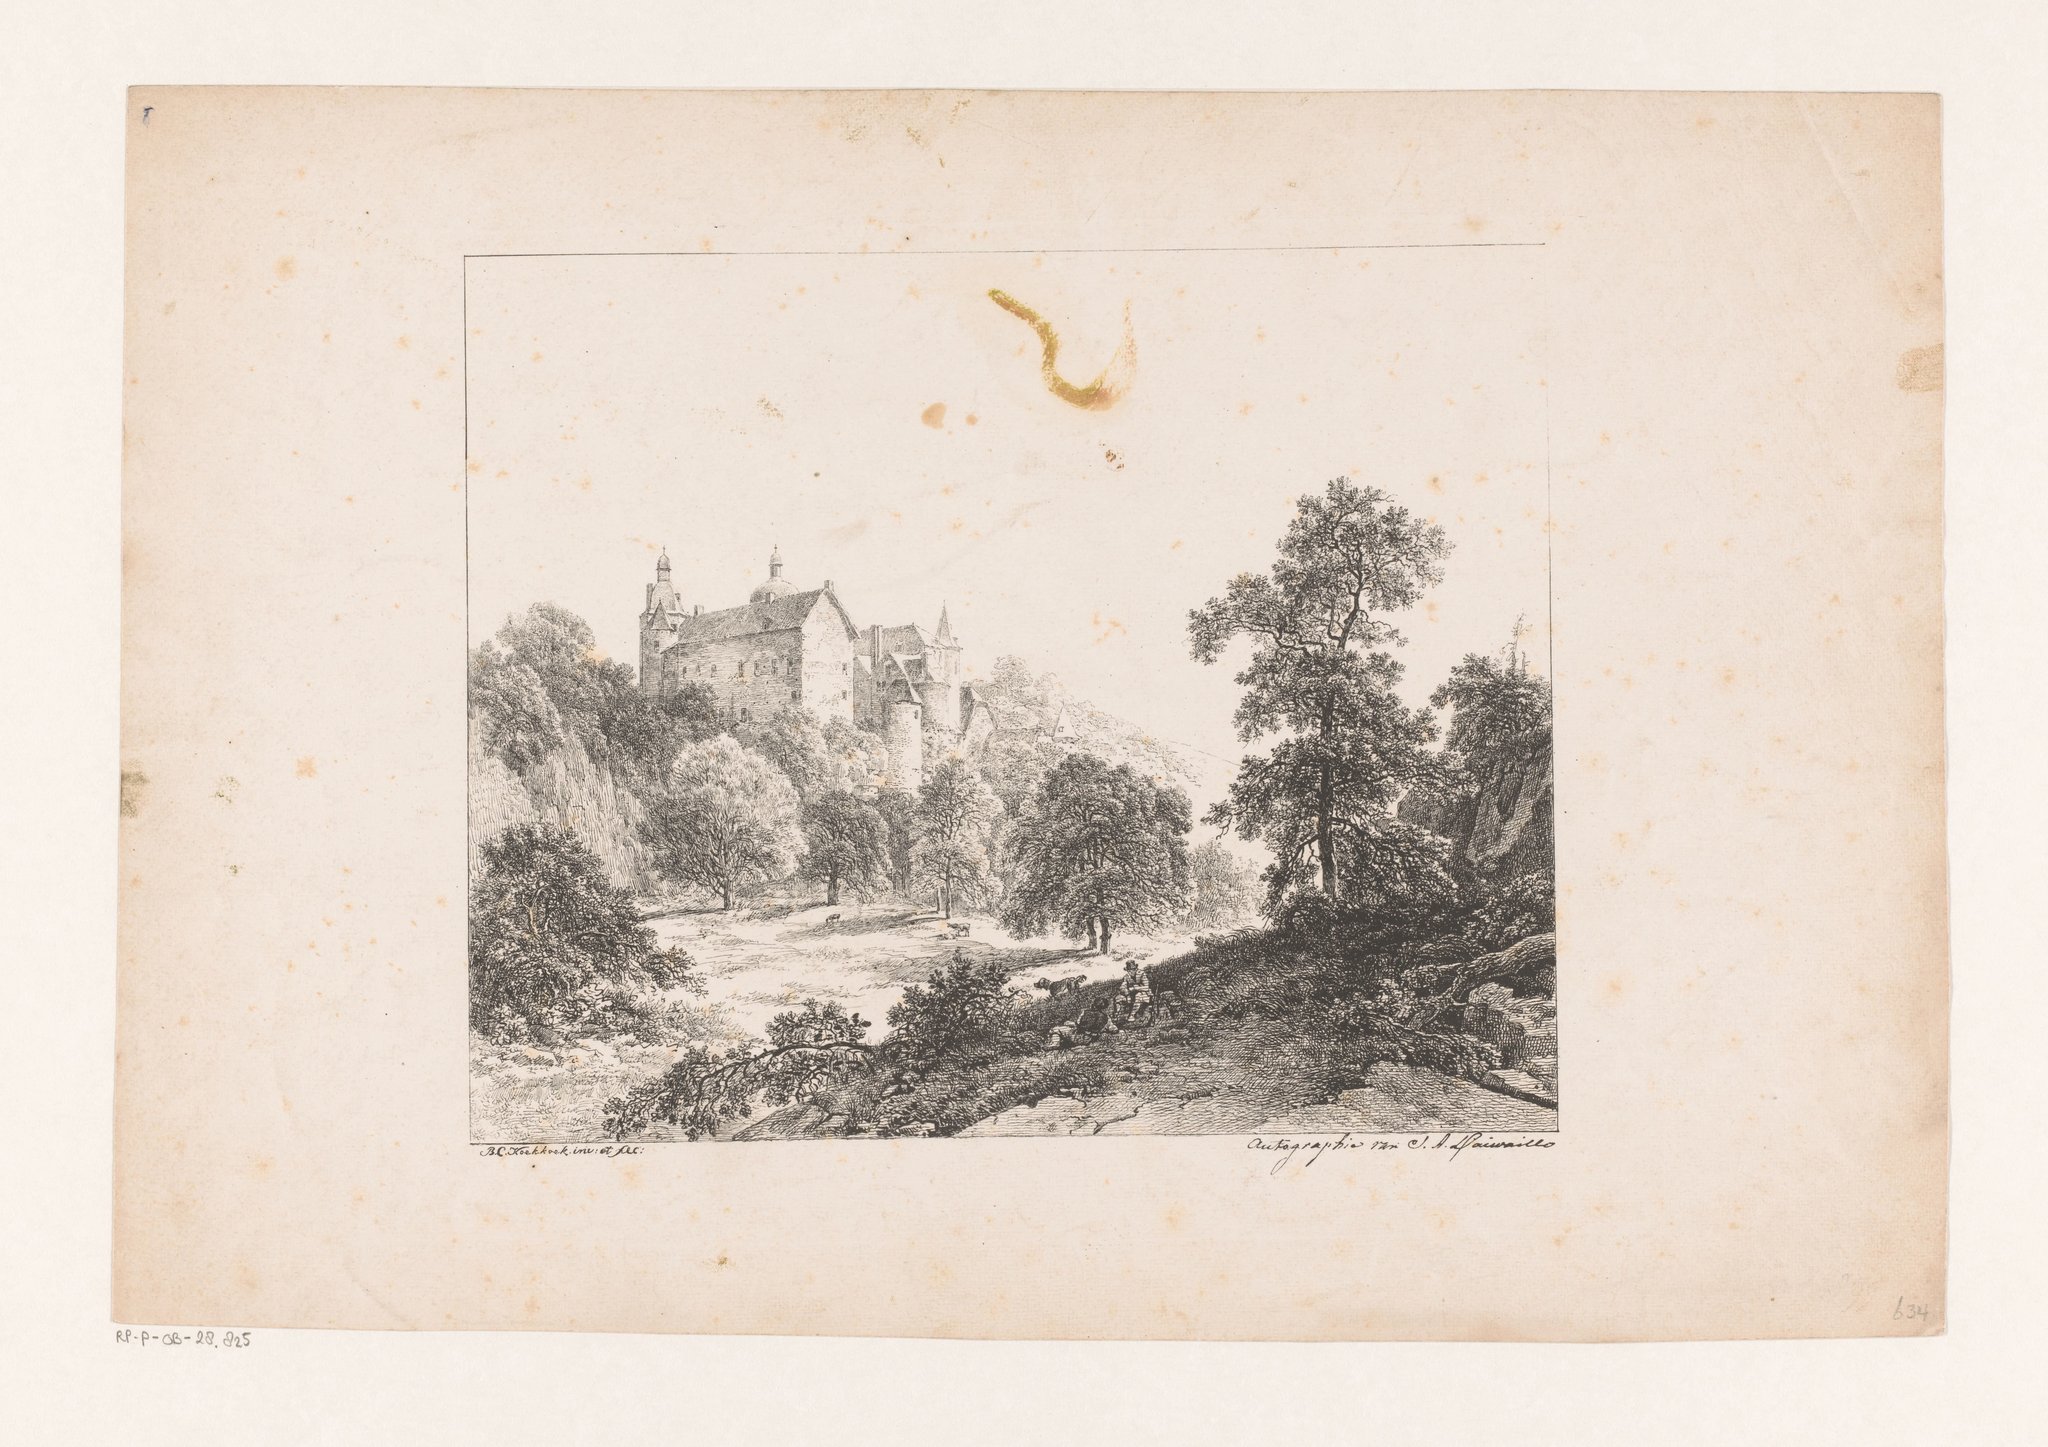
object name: print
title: Environs de Namur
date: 1820-1862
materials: paper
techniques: lithograph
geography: amsterdam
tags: landscape with tower or castle, landscapes in the temperate zone (+ landscape with figures, staffage)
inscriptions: collector's mark: Lugt 2228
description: Het woord 'autographie' rechtsonder op de prent verwijst, volgens C. J. de Bruyn Kops in het Bulletin van het Rijksmuseum, naar een techniek waarbij op glad papier werd getekend. Deze tekening werd vervolgens op de steen overgebracht. Tot slot werd hiermee gedrukt. Dit had het effect dat de afbeelding niet in spiegelbeeld werd afgedrukt en de tekenaar dus ook niet in spiegelbeeld hoefde te werken.